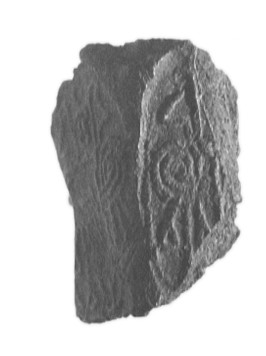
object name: sealing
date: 2030-1640 BCE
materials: clay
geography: egypt